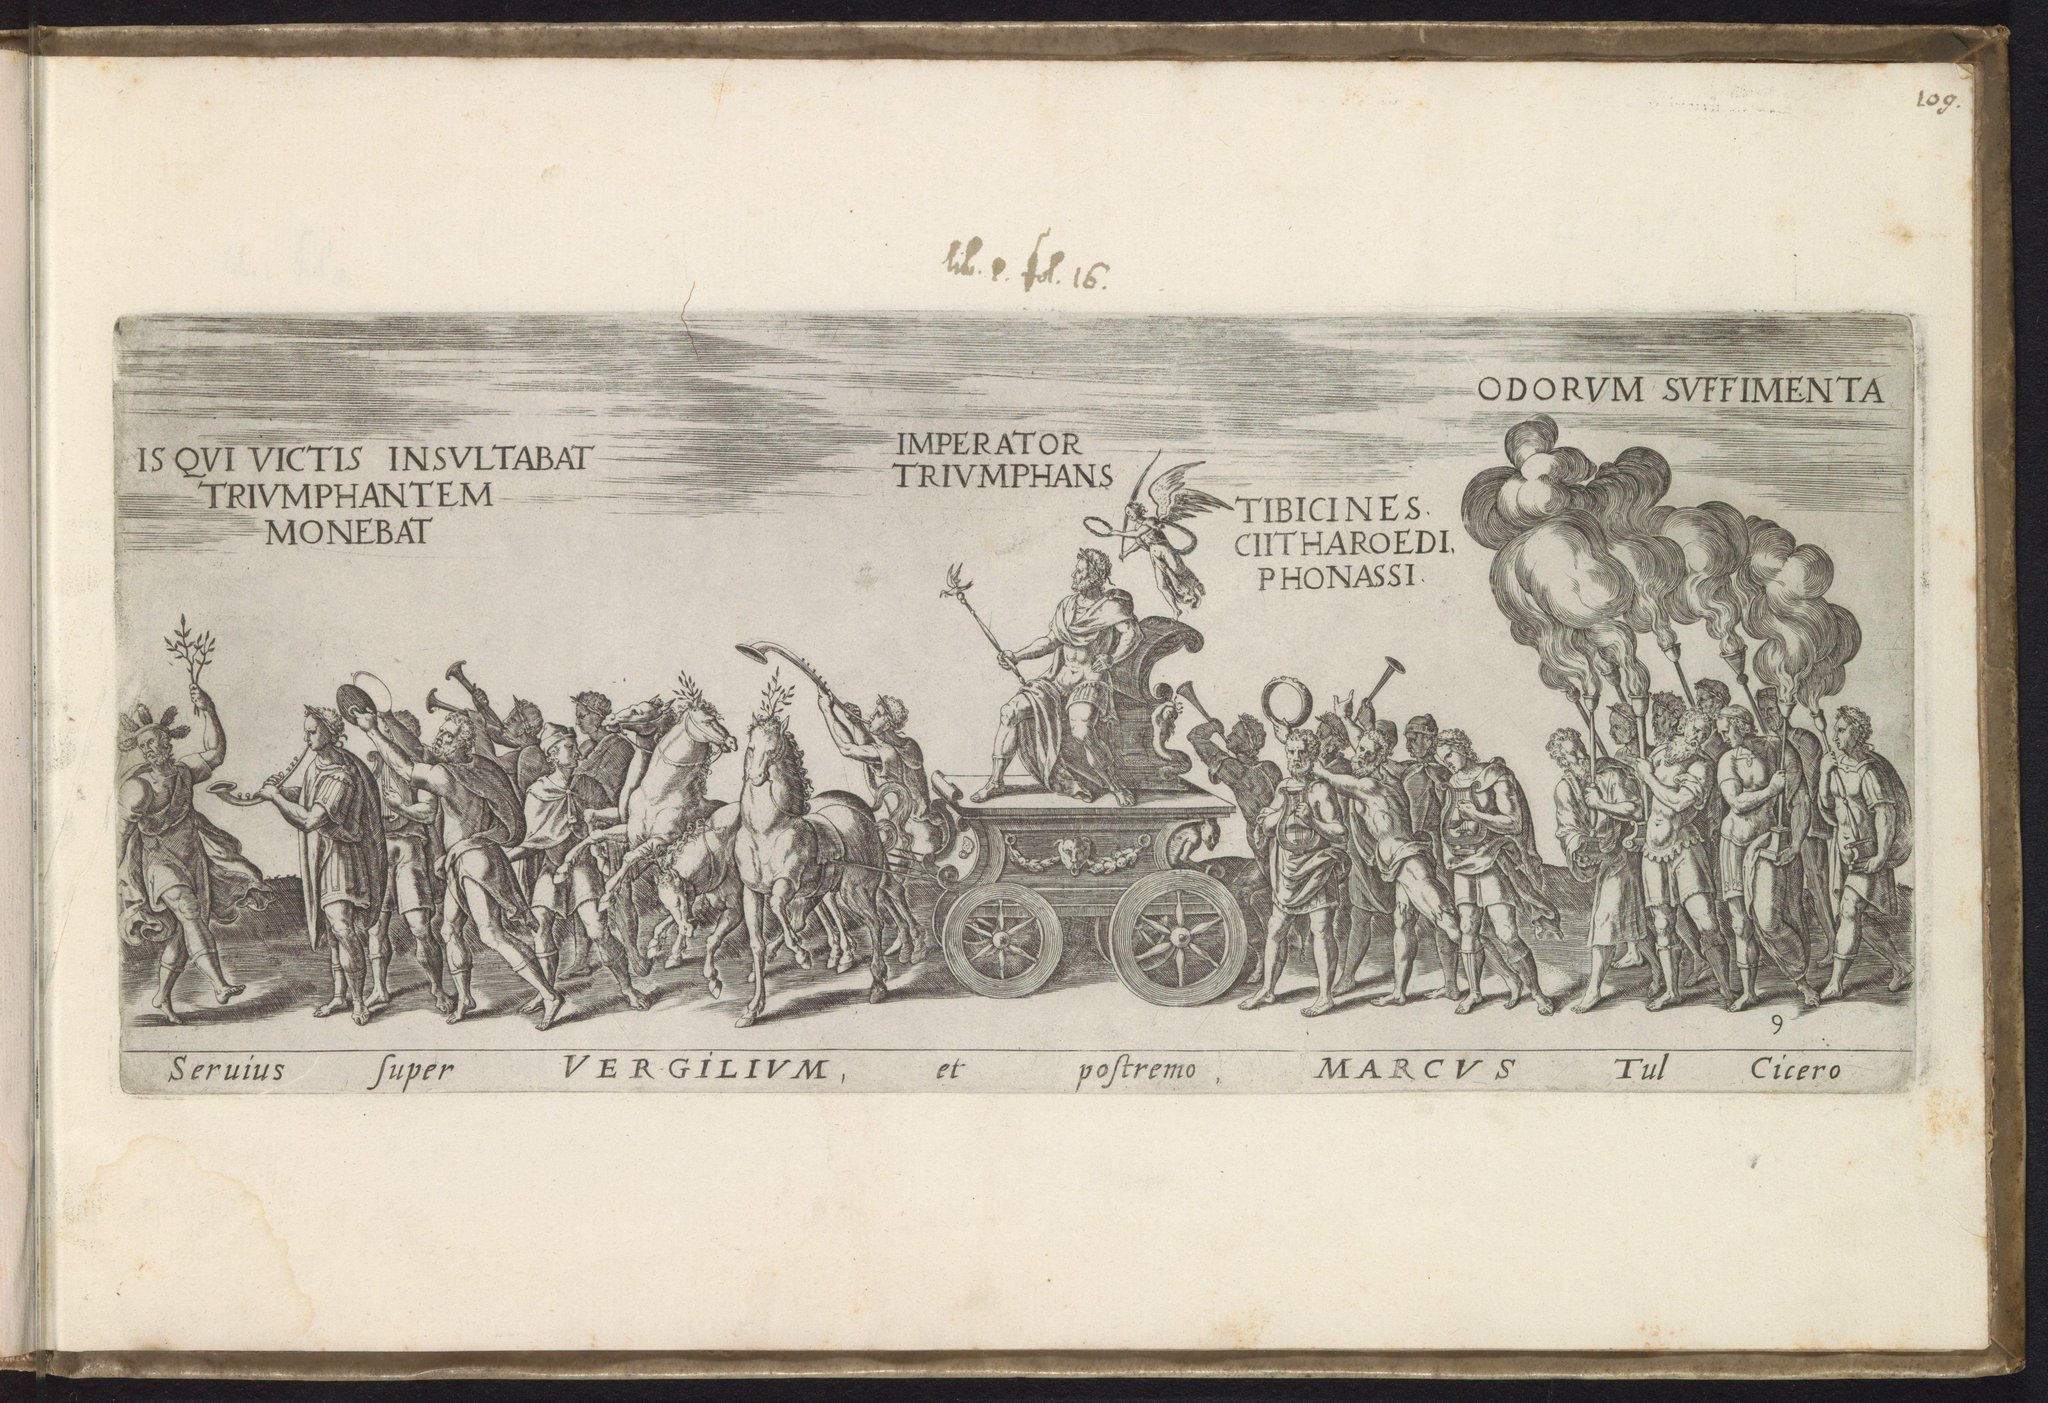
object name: album leaf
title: Romeinse triomfen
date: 1618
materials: paper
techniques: engraving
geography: rome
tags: ceremonial procession, parade, pageant ~ installation of a ruler, priest ~ roman religion, musician, roman chariot, quadriga ~ triumph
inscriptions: number: ‘109’, inscription: ‘lib. 1. fol. 16’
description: Processie van muzikanten, priesters met rokende wierook en de keizer tronend op een triomfwagen die wordt voortgetrokken door paarden. Titel in het Latijn in ondermarge. Prent maakt deel uit van een album.